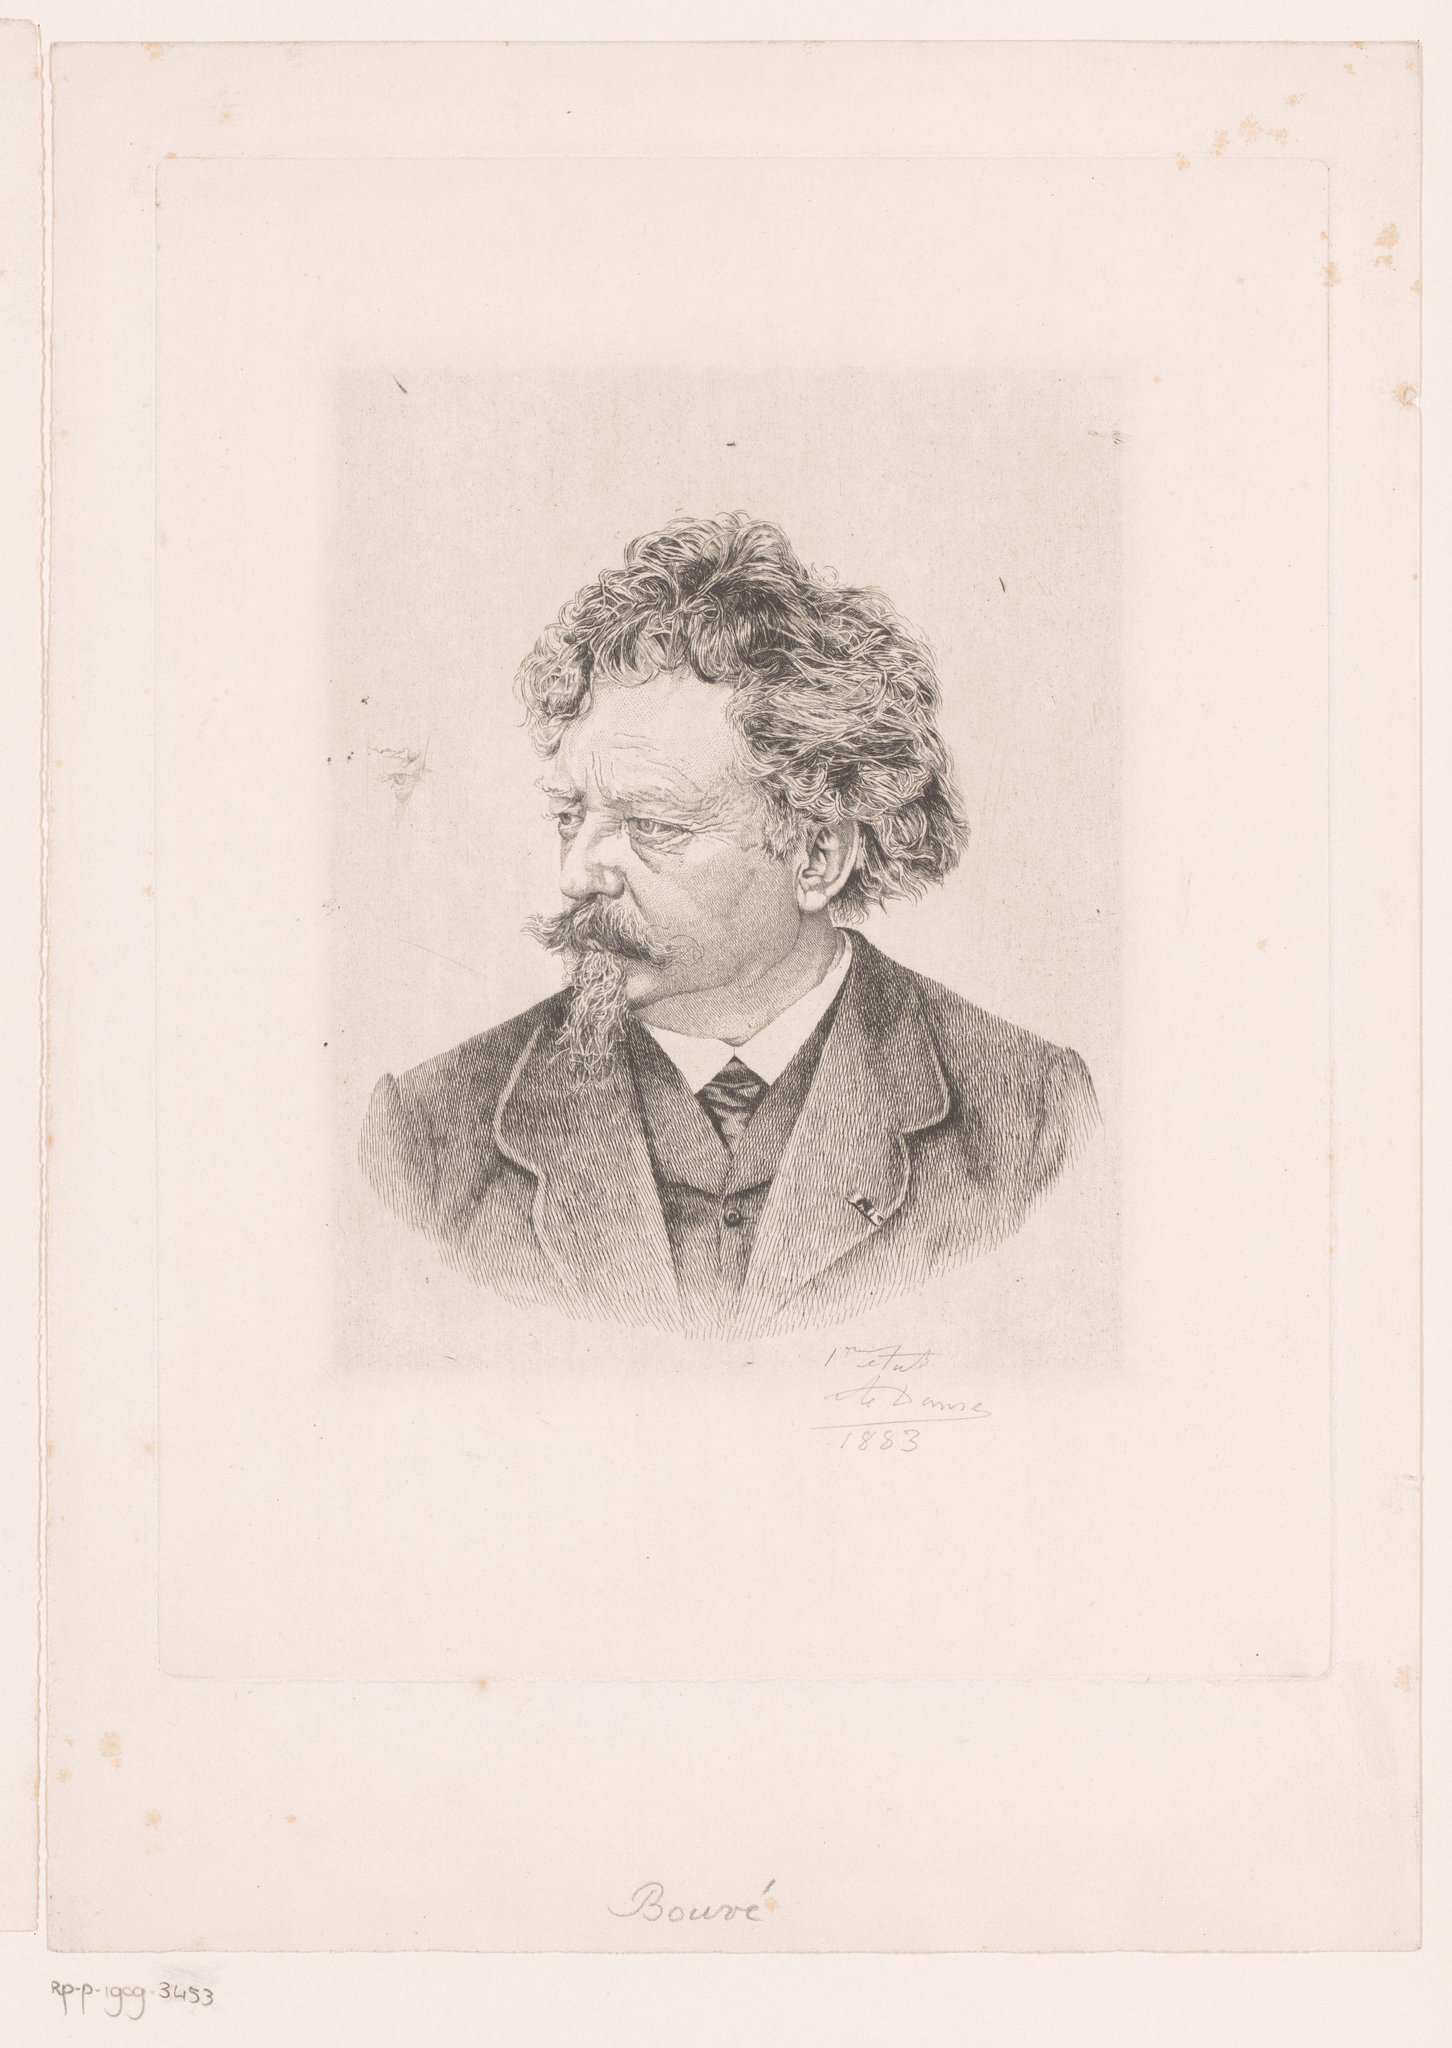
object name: print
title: Portret van een onbekende man, mogelijk Bouvé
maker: auguste danse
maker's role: print maker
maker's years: 1829-1929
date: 1883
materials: paper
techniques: etching, intaglio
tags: anonymous historical person portrayed alone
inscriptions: annotation: ‘1er état’, collector's mark: Lugt 2228